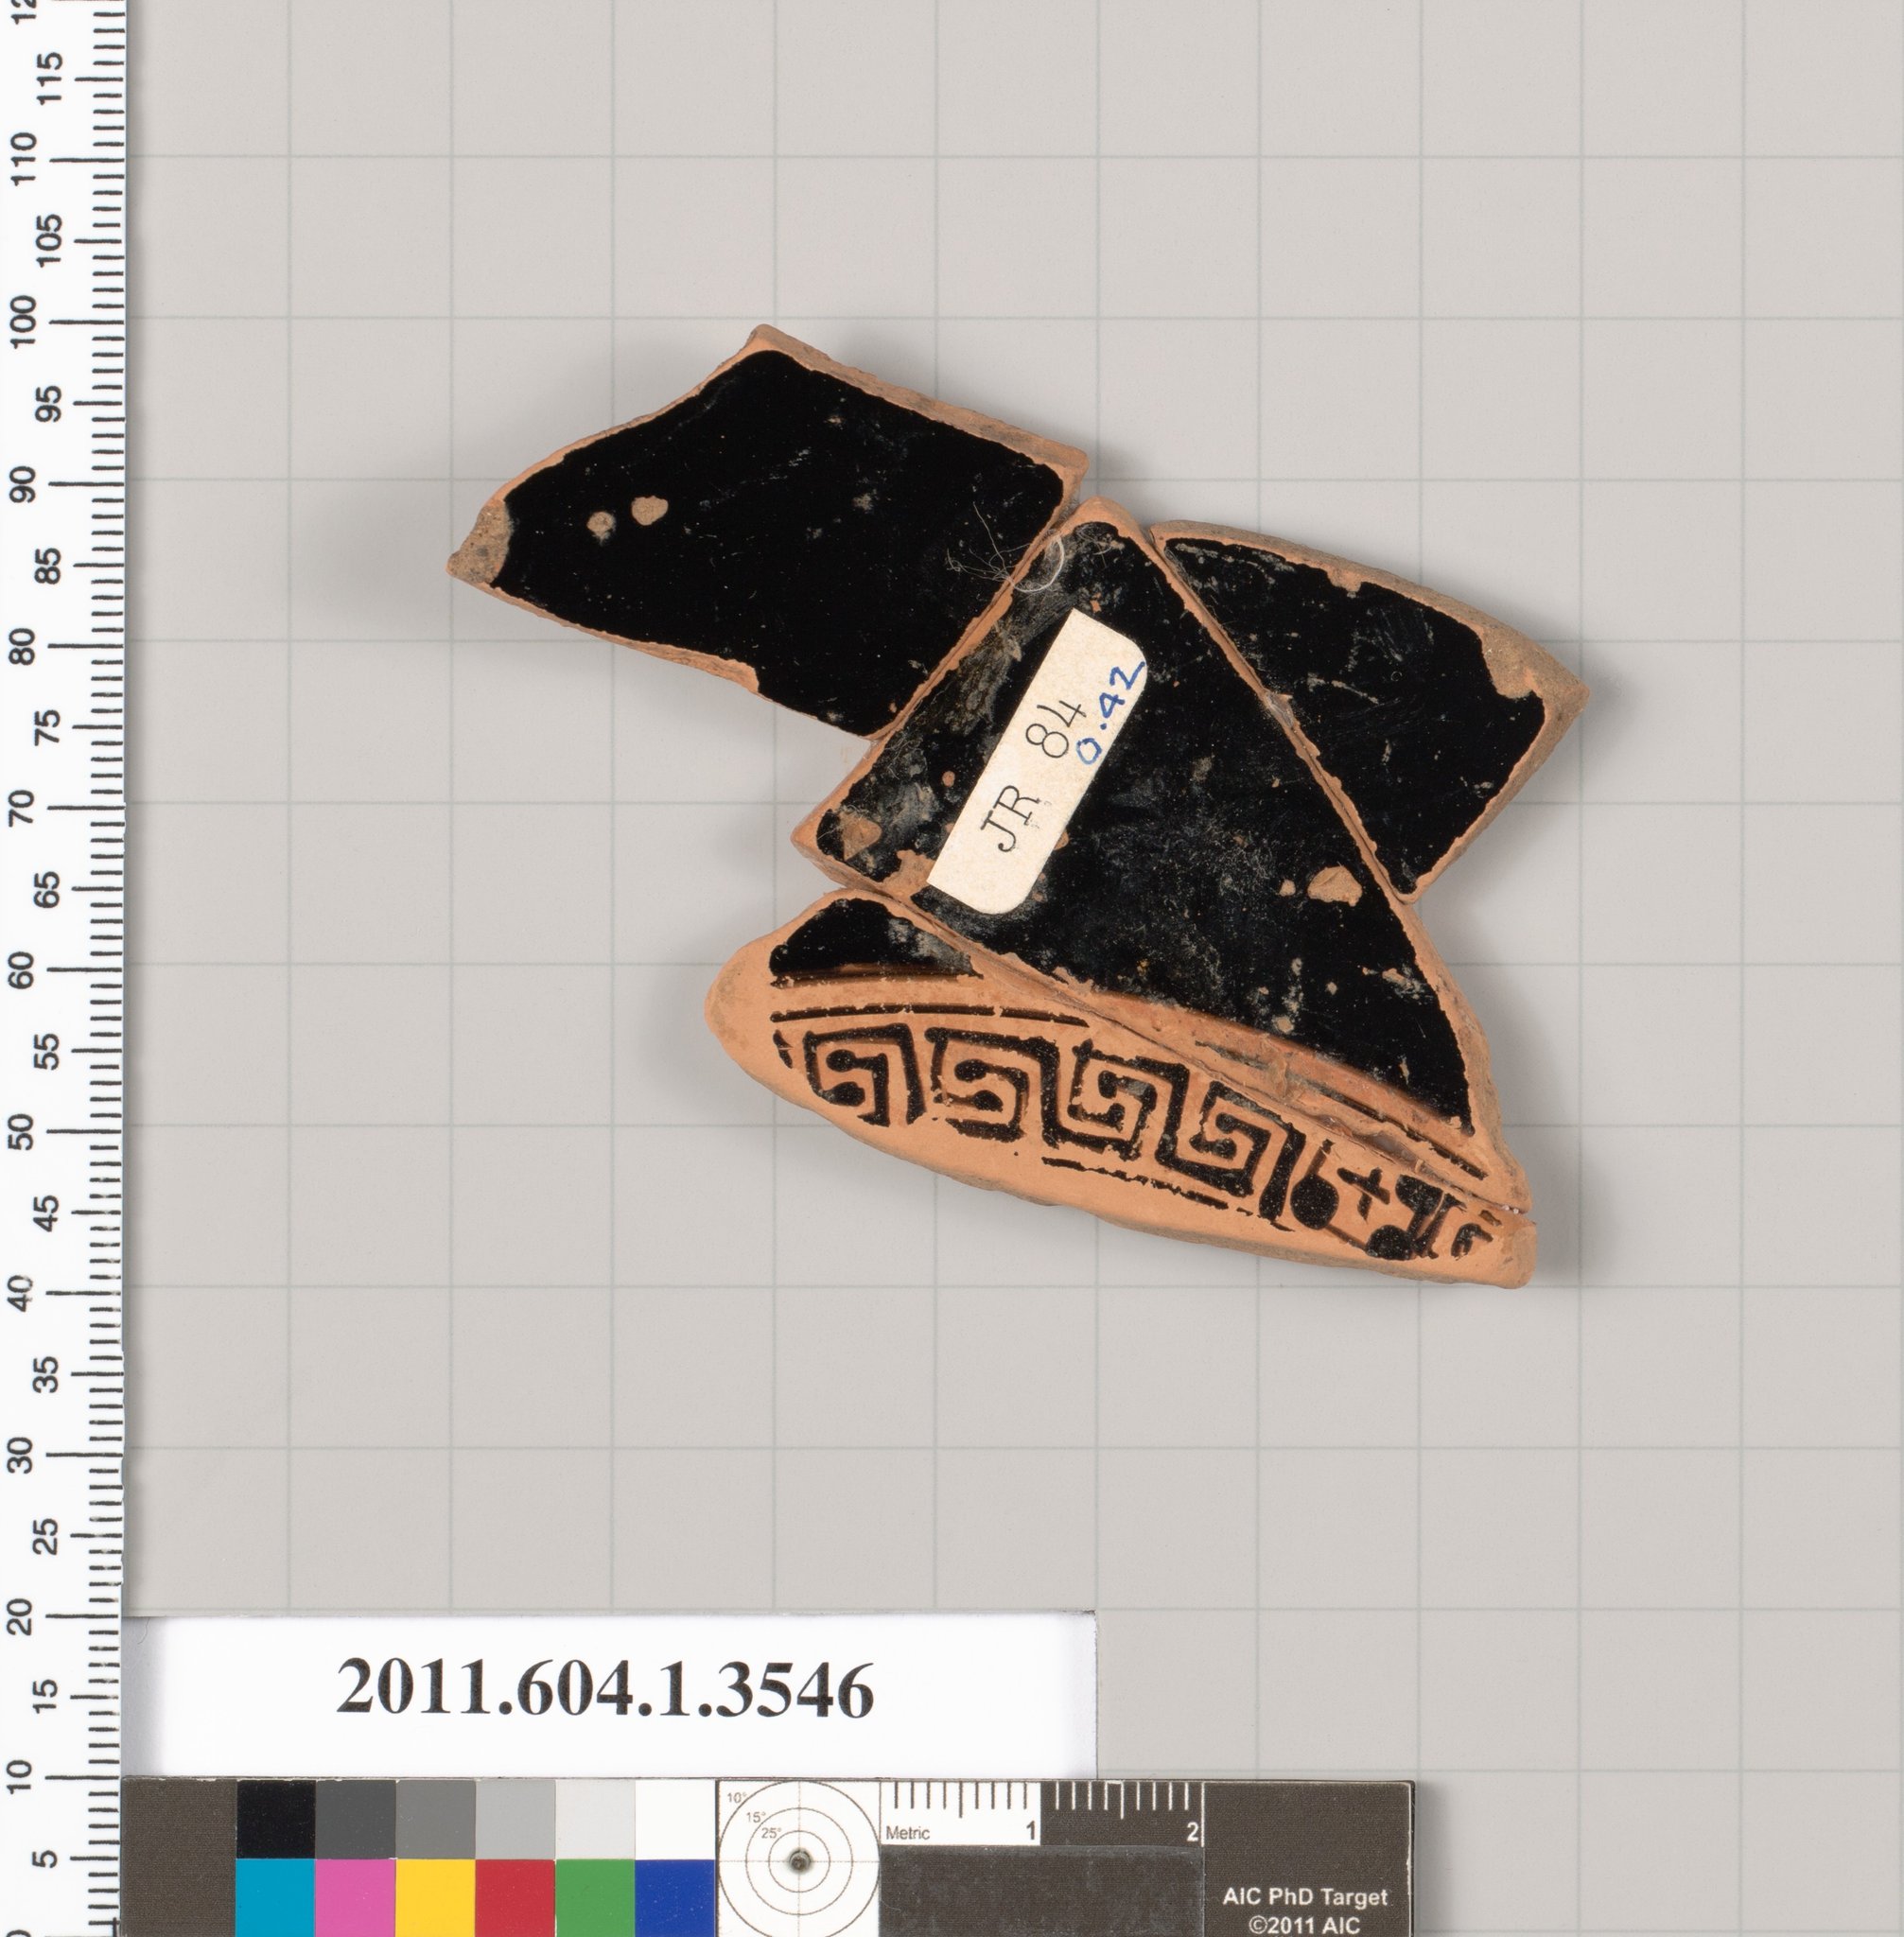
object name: kylix fragment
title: Terracotta fragment of a kylix (drinking cup)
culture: greek, attic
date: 475-451 BCE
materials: terracotta